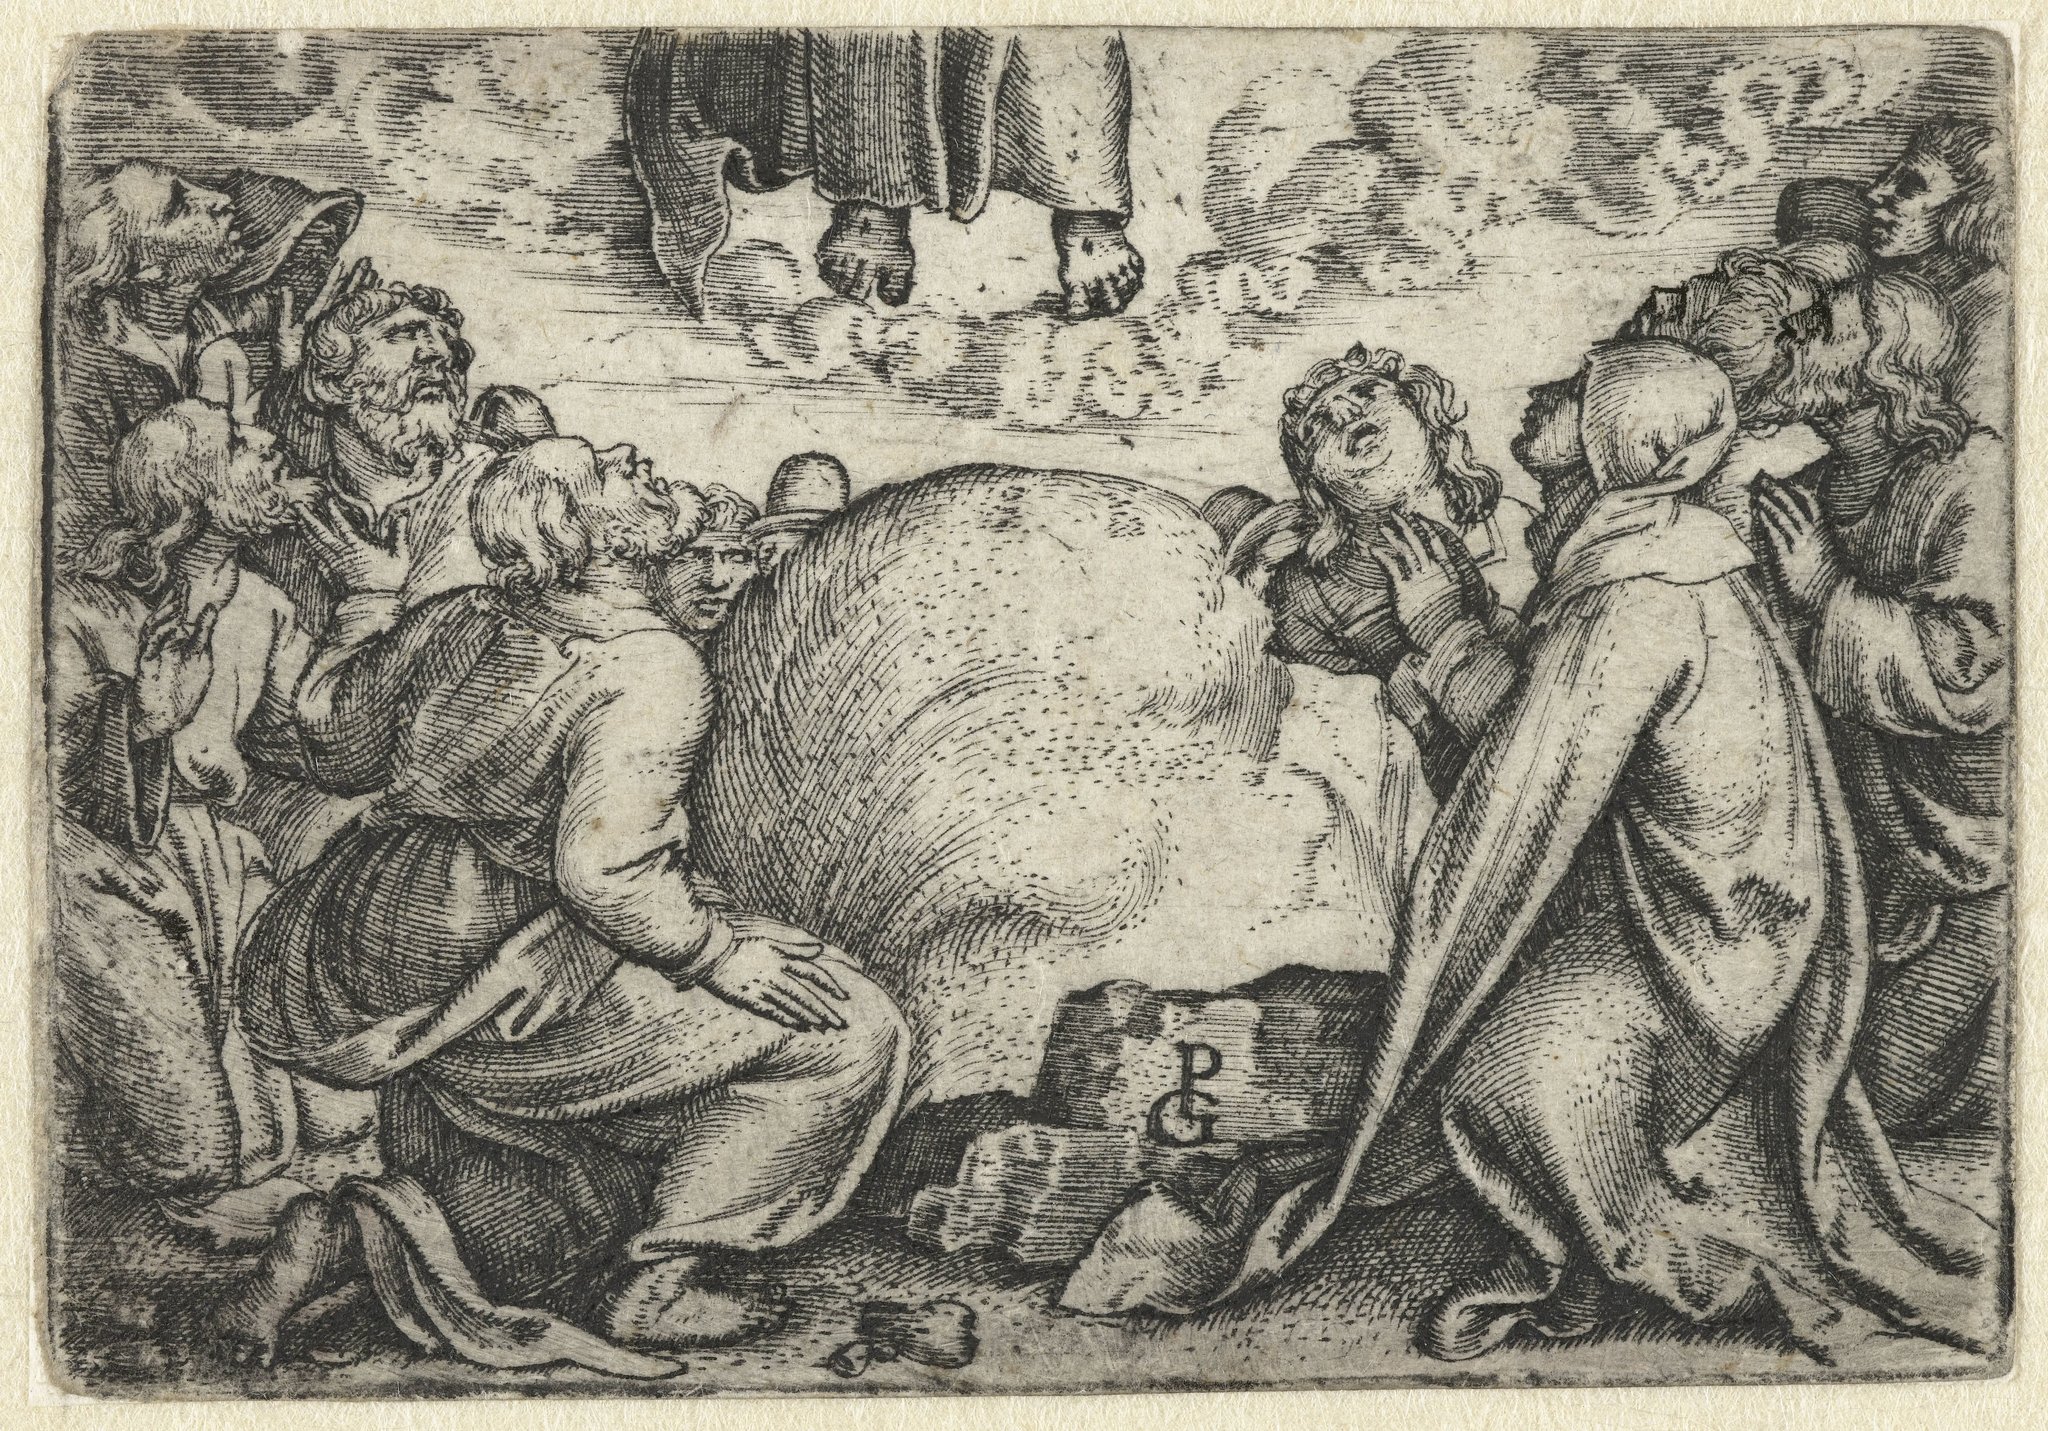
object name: print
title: Leven van Christus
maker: georg pencz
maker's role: draughtsman, painter, print maker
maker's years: 1500-1550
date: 1535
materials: paper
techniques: engraving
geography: germany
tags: the ascension (christ surrounded by radiant light or in a mandorla)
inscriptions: collector's mark: ‘Hinloopem’ Lugt 11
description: Christus verdwijnt tussen de wolken onder het toeziend oog van zijn apostelen op de Olijfberg. Op deze voorstelling zijn slechts Christus voeten zichtbaar, de rest van zijn lichaam wordt afgesneden door de beeldrand.